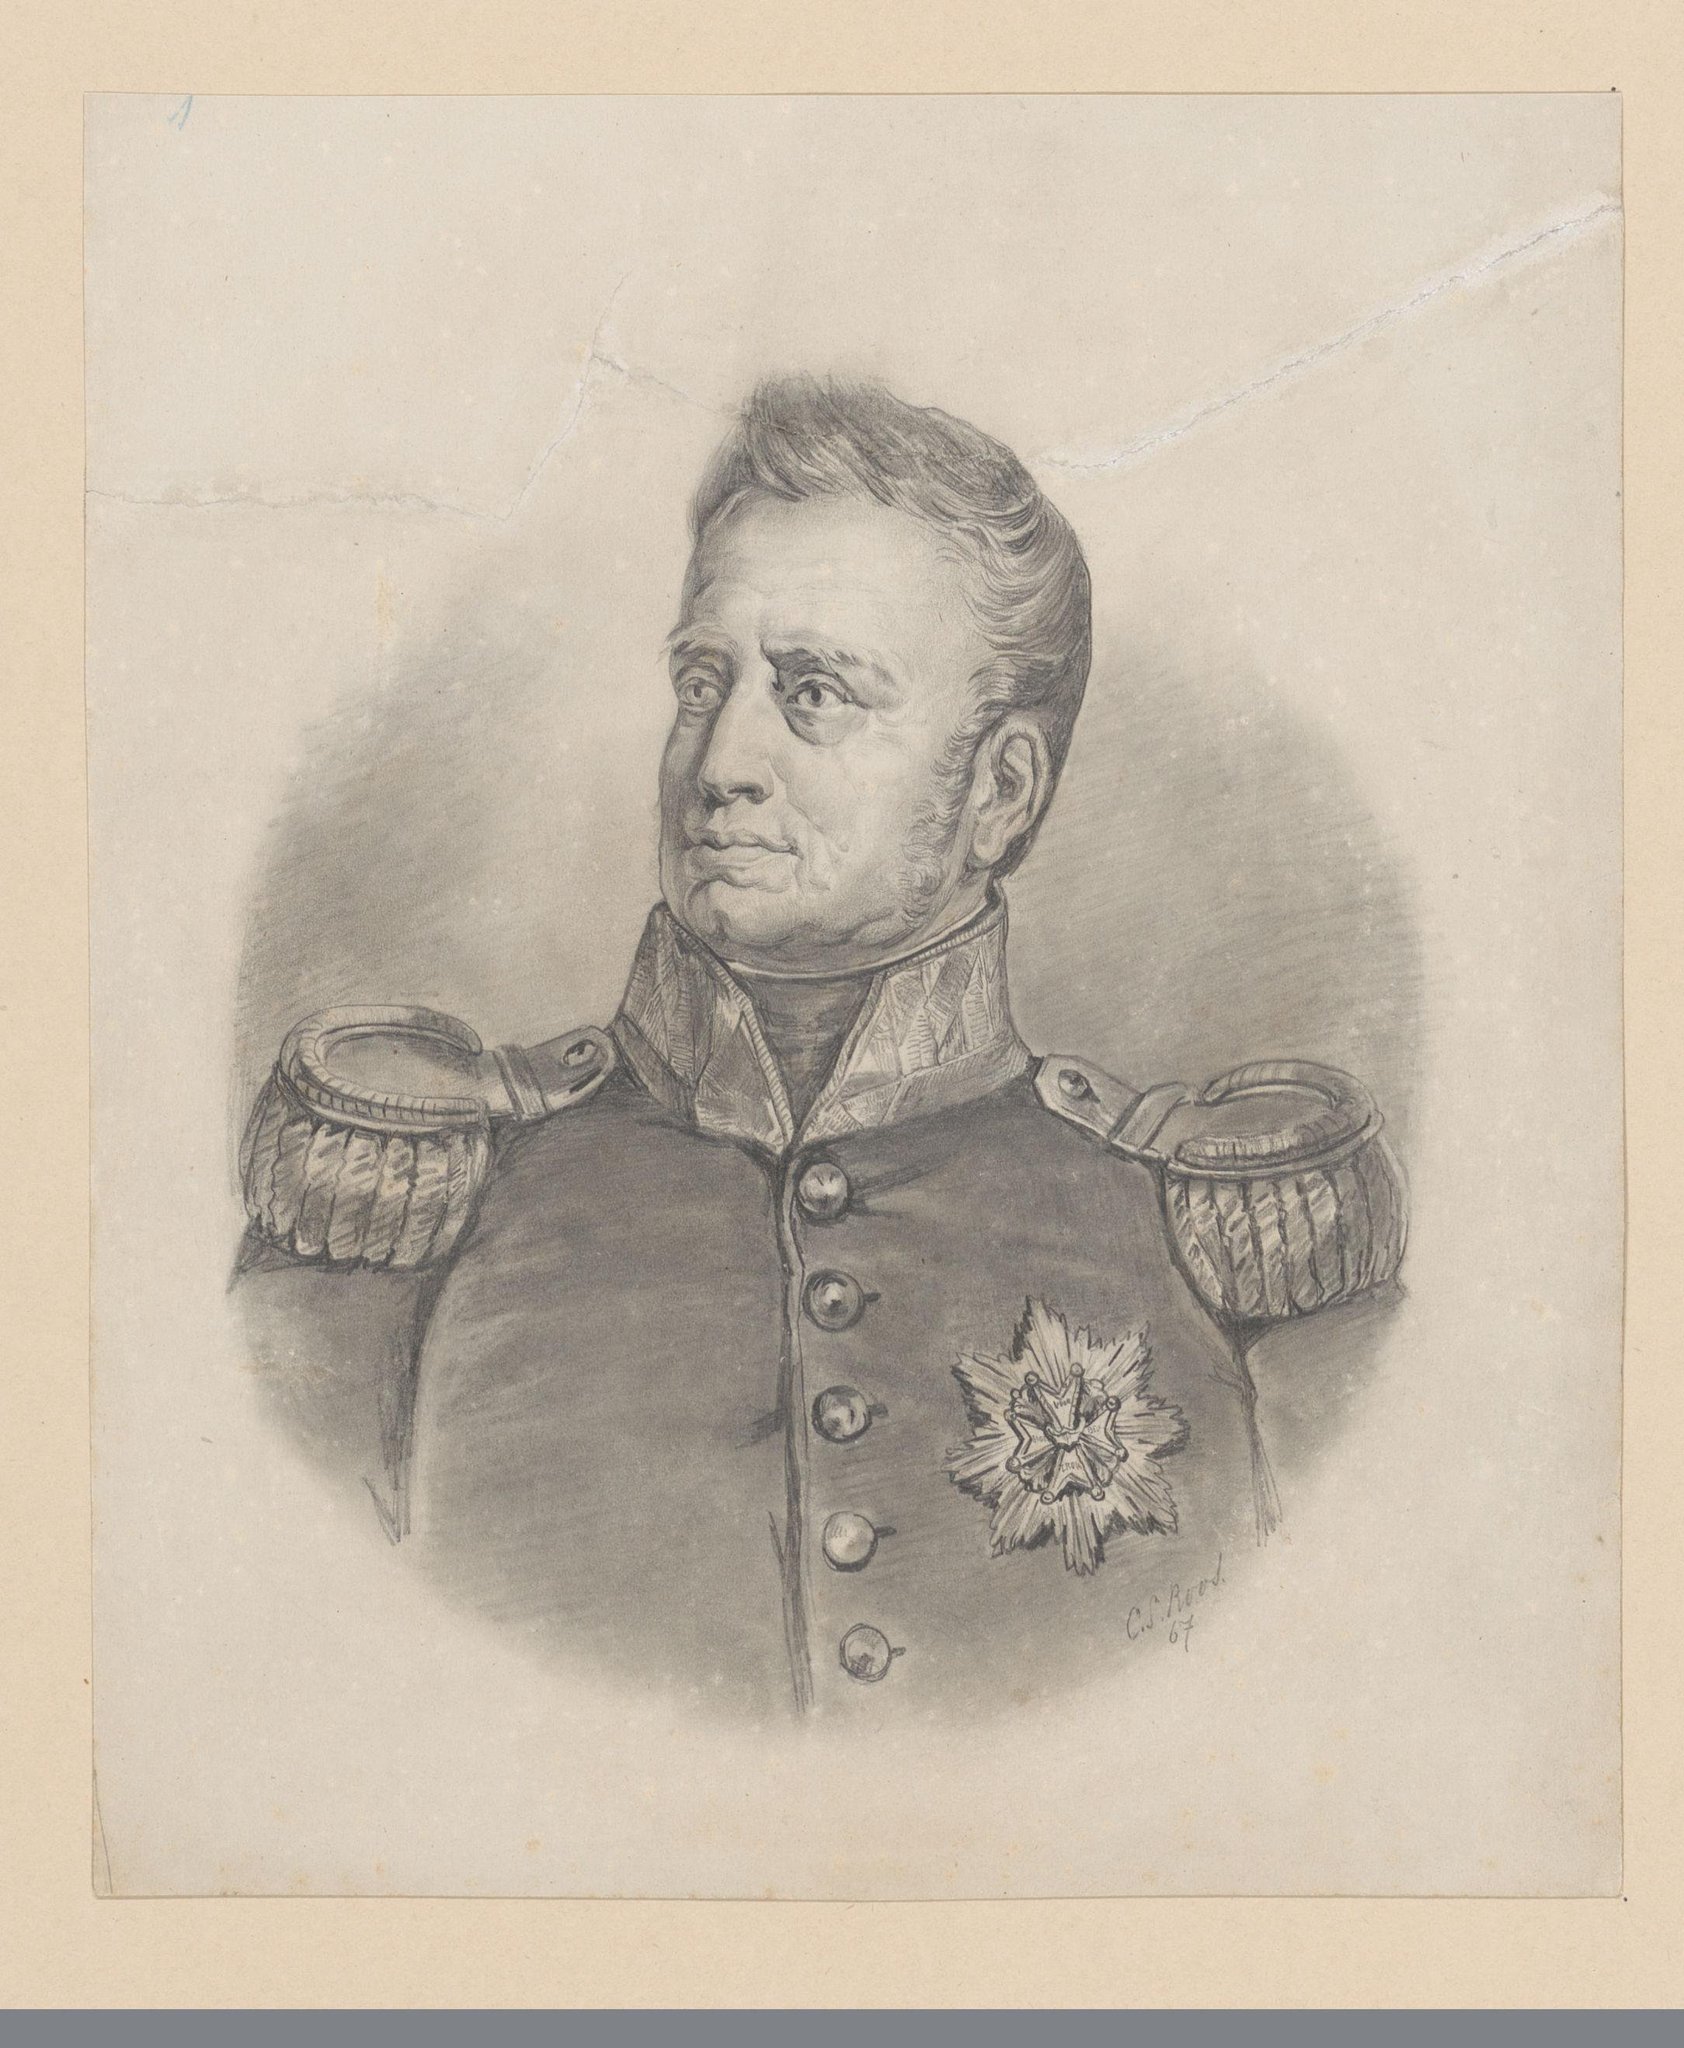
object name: drawing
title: Portret van koning Willem I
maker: cornelis sebille roos (uitgever)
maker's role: auctioneer, draughtsman, publisher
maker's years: 1754-1820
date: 1867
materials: paper, pencil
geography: netherlands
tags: the hague, berlin, william i of the netherlands, historical persons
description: Portret van koning Willem I, borstbeeld naar links, ridderorde op de borst.